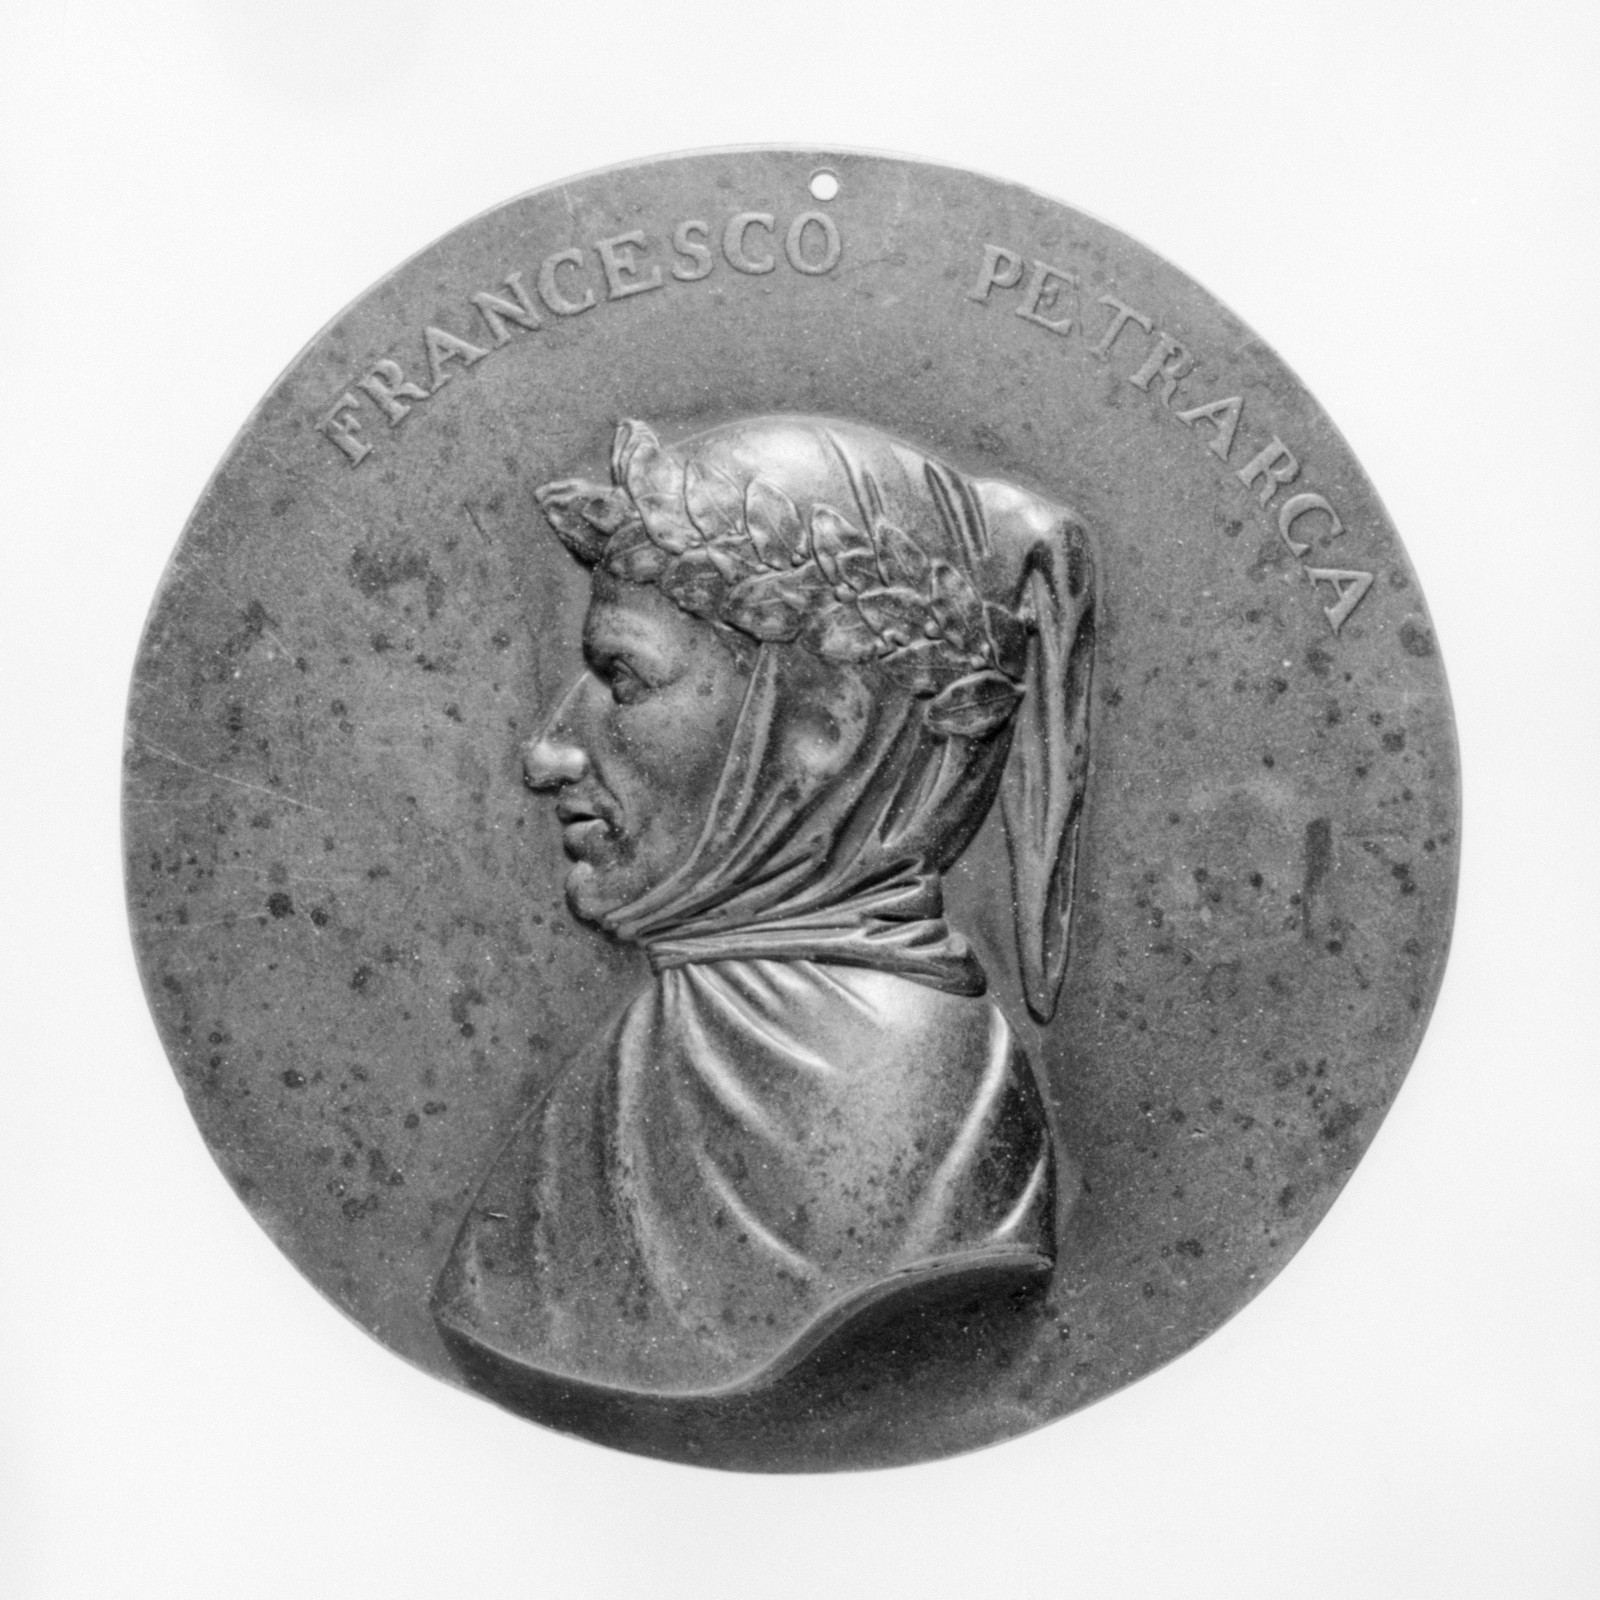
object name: medal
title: Petrarch (1304–1374)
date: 1701-1900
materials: bronze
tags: men,profiles